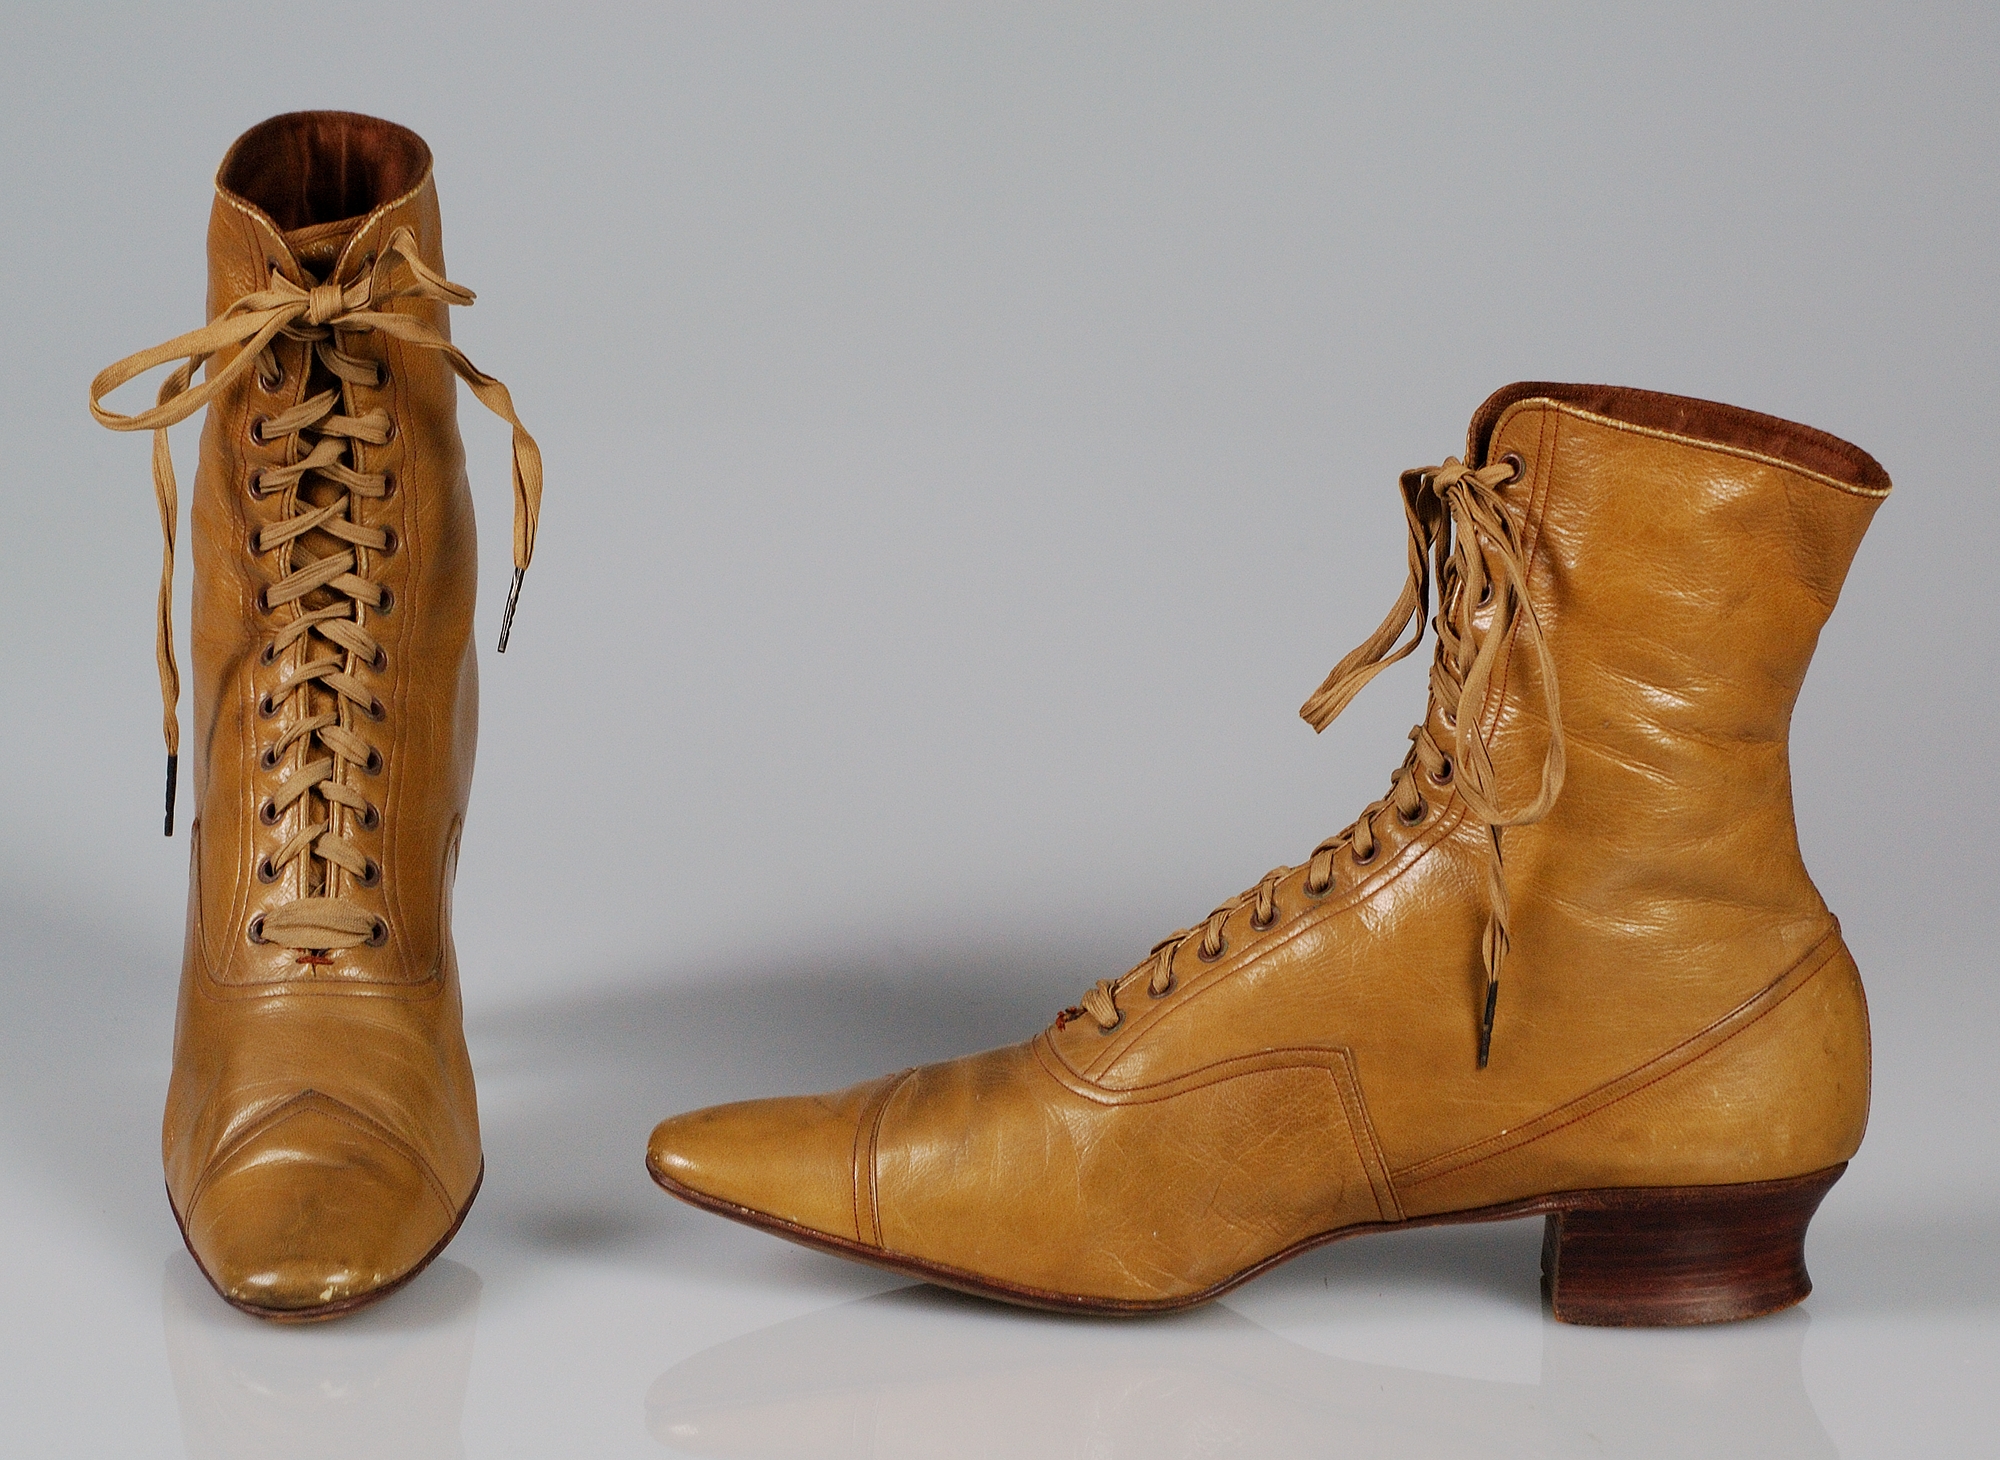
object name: boot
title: Boots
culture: american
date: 1890-1895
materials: leather